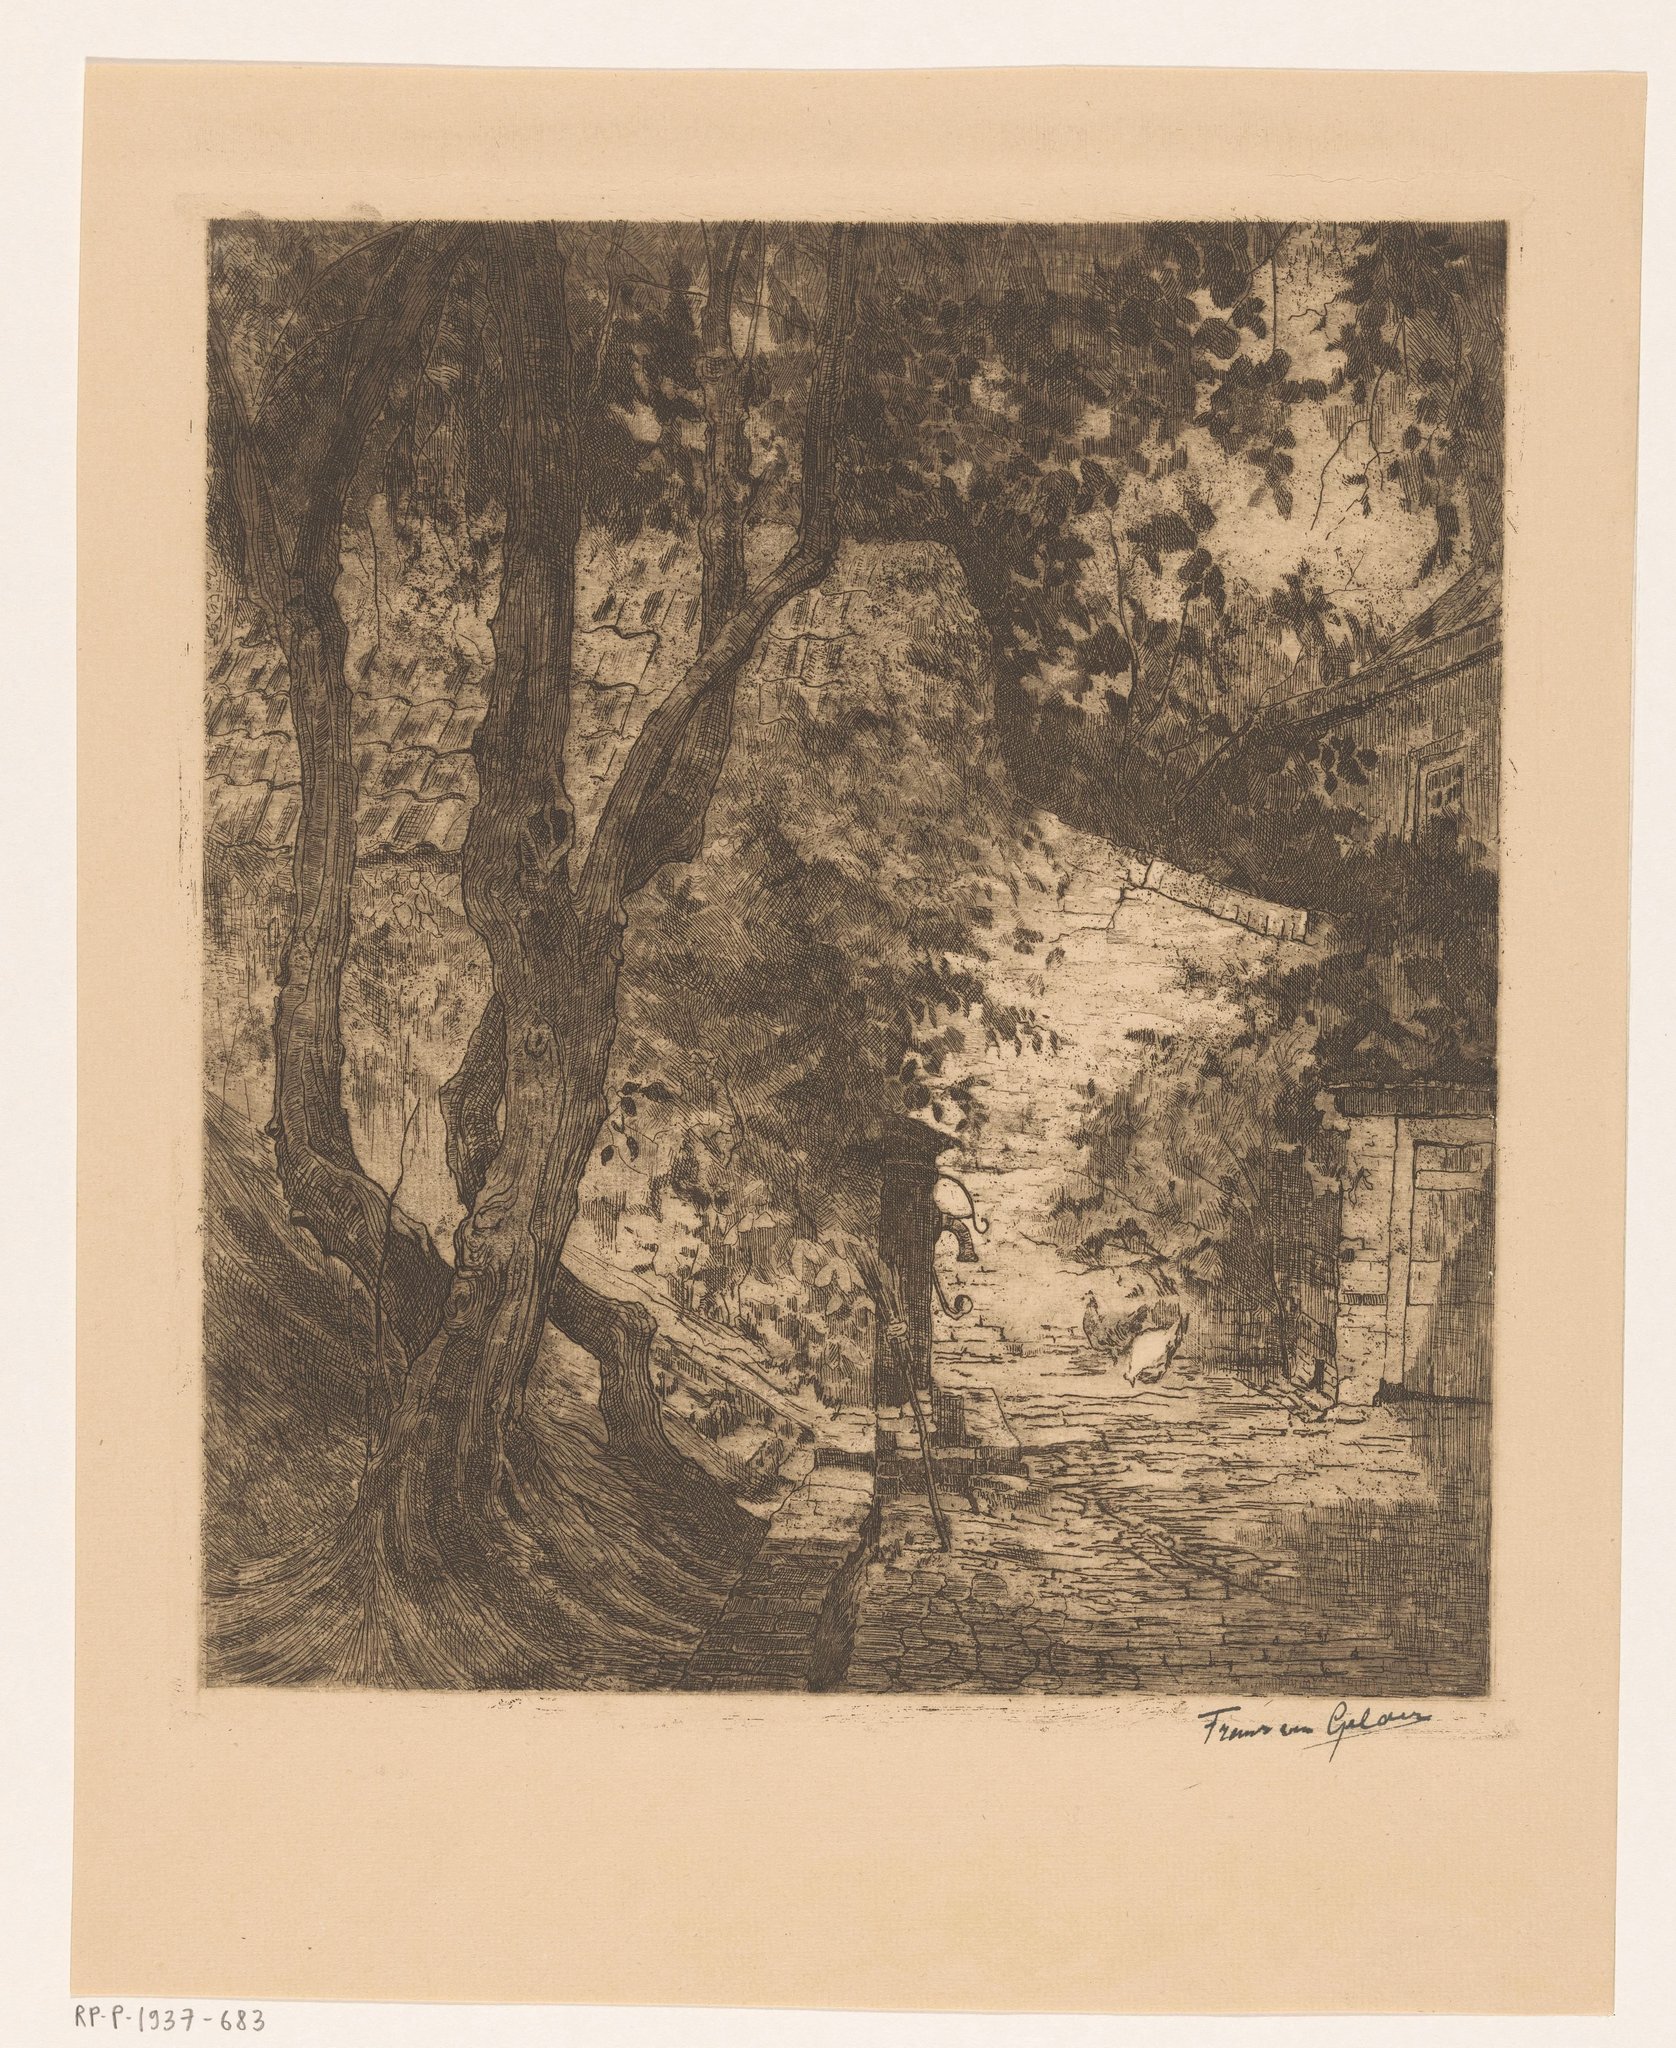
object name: print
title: Binnenplaats met bomen, waterpomp en kippen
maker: franciscus van gelder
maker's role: print maker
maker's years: 1876-1935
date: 1886-1935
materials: paper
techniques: aquatint, etching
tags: well, fowl (cock, hen, chicken, etc.), courtyard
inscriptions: collector's mark: Lugt 2228, collector's mark: Lugt 2760